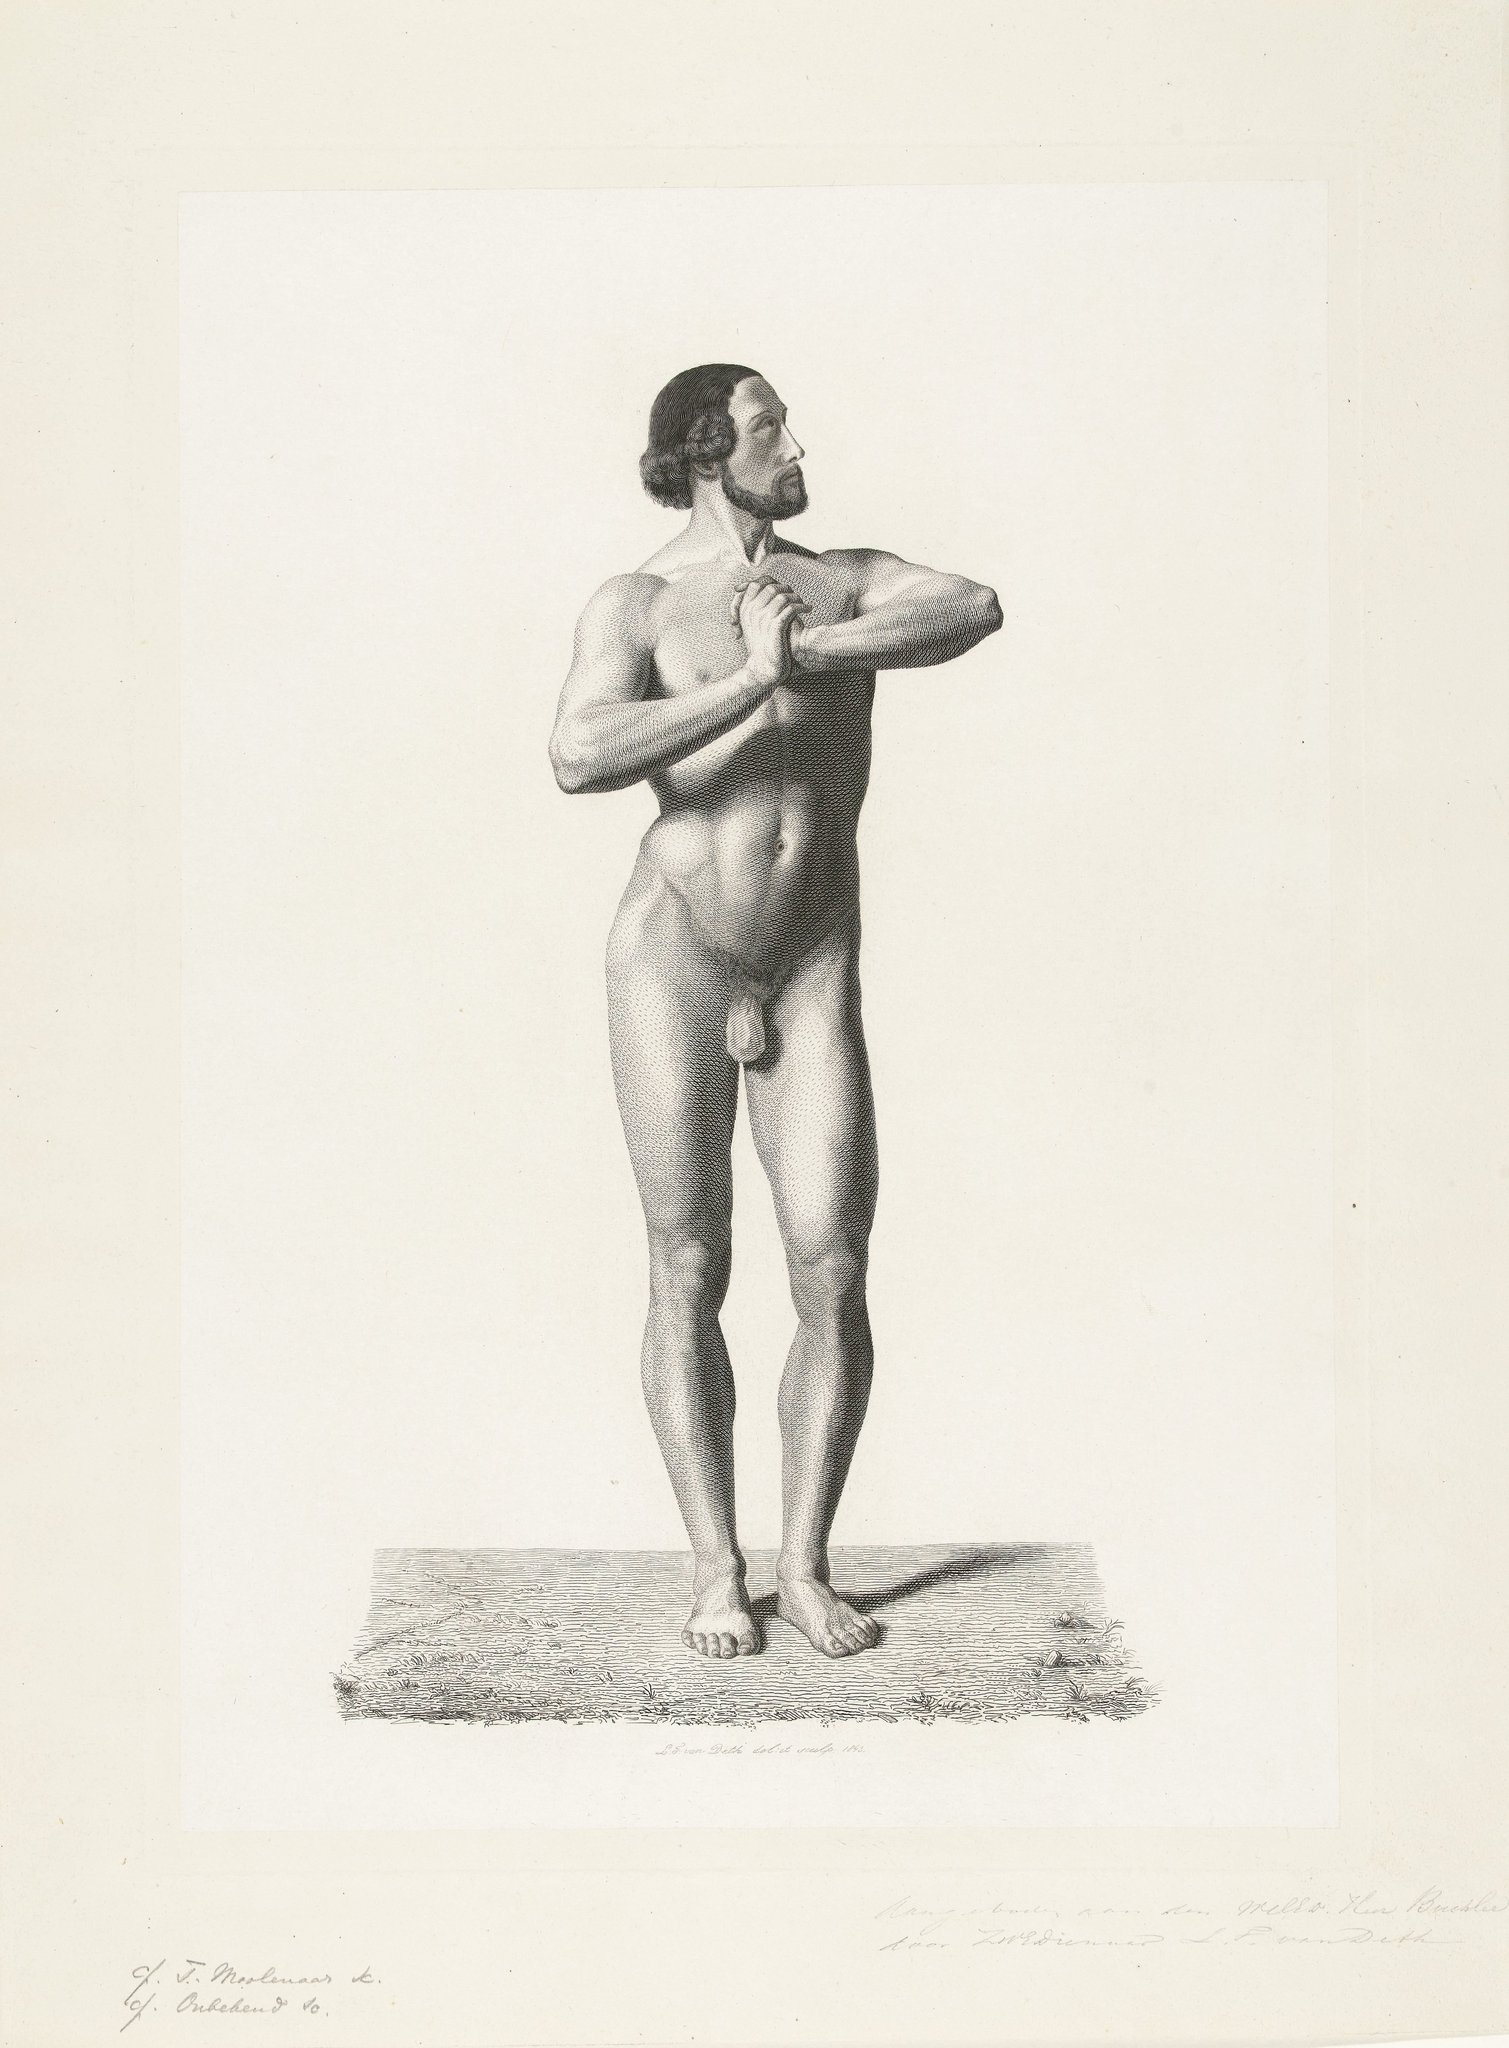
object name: print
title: Staand mannelijk naakt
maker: lubertus teunis van deth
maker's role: draughtsman, print maker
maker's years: 1814-1875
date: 1843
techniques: printmaking, engraving, etching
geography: netherlands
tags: human figure of ideal proportions, e.g. academic nude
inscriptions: collector's mark: Lugt 2228, inscription: ‘Aangeboden aan den WelEd. Heer Buchler door ZnEdienaar L.T. van Deth’